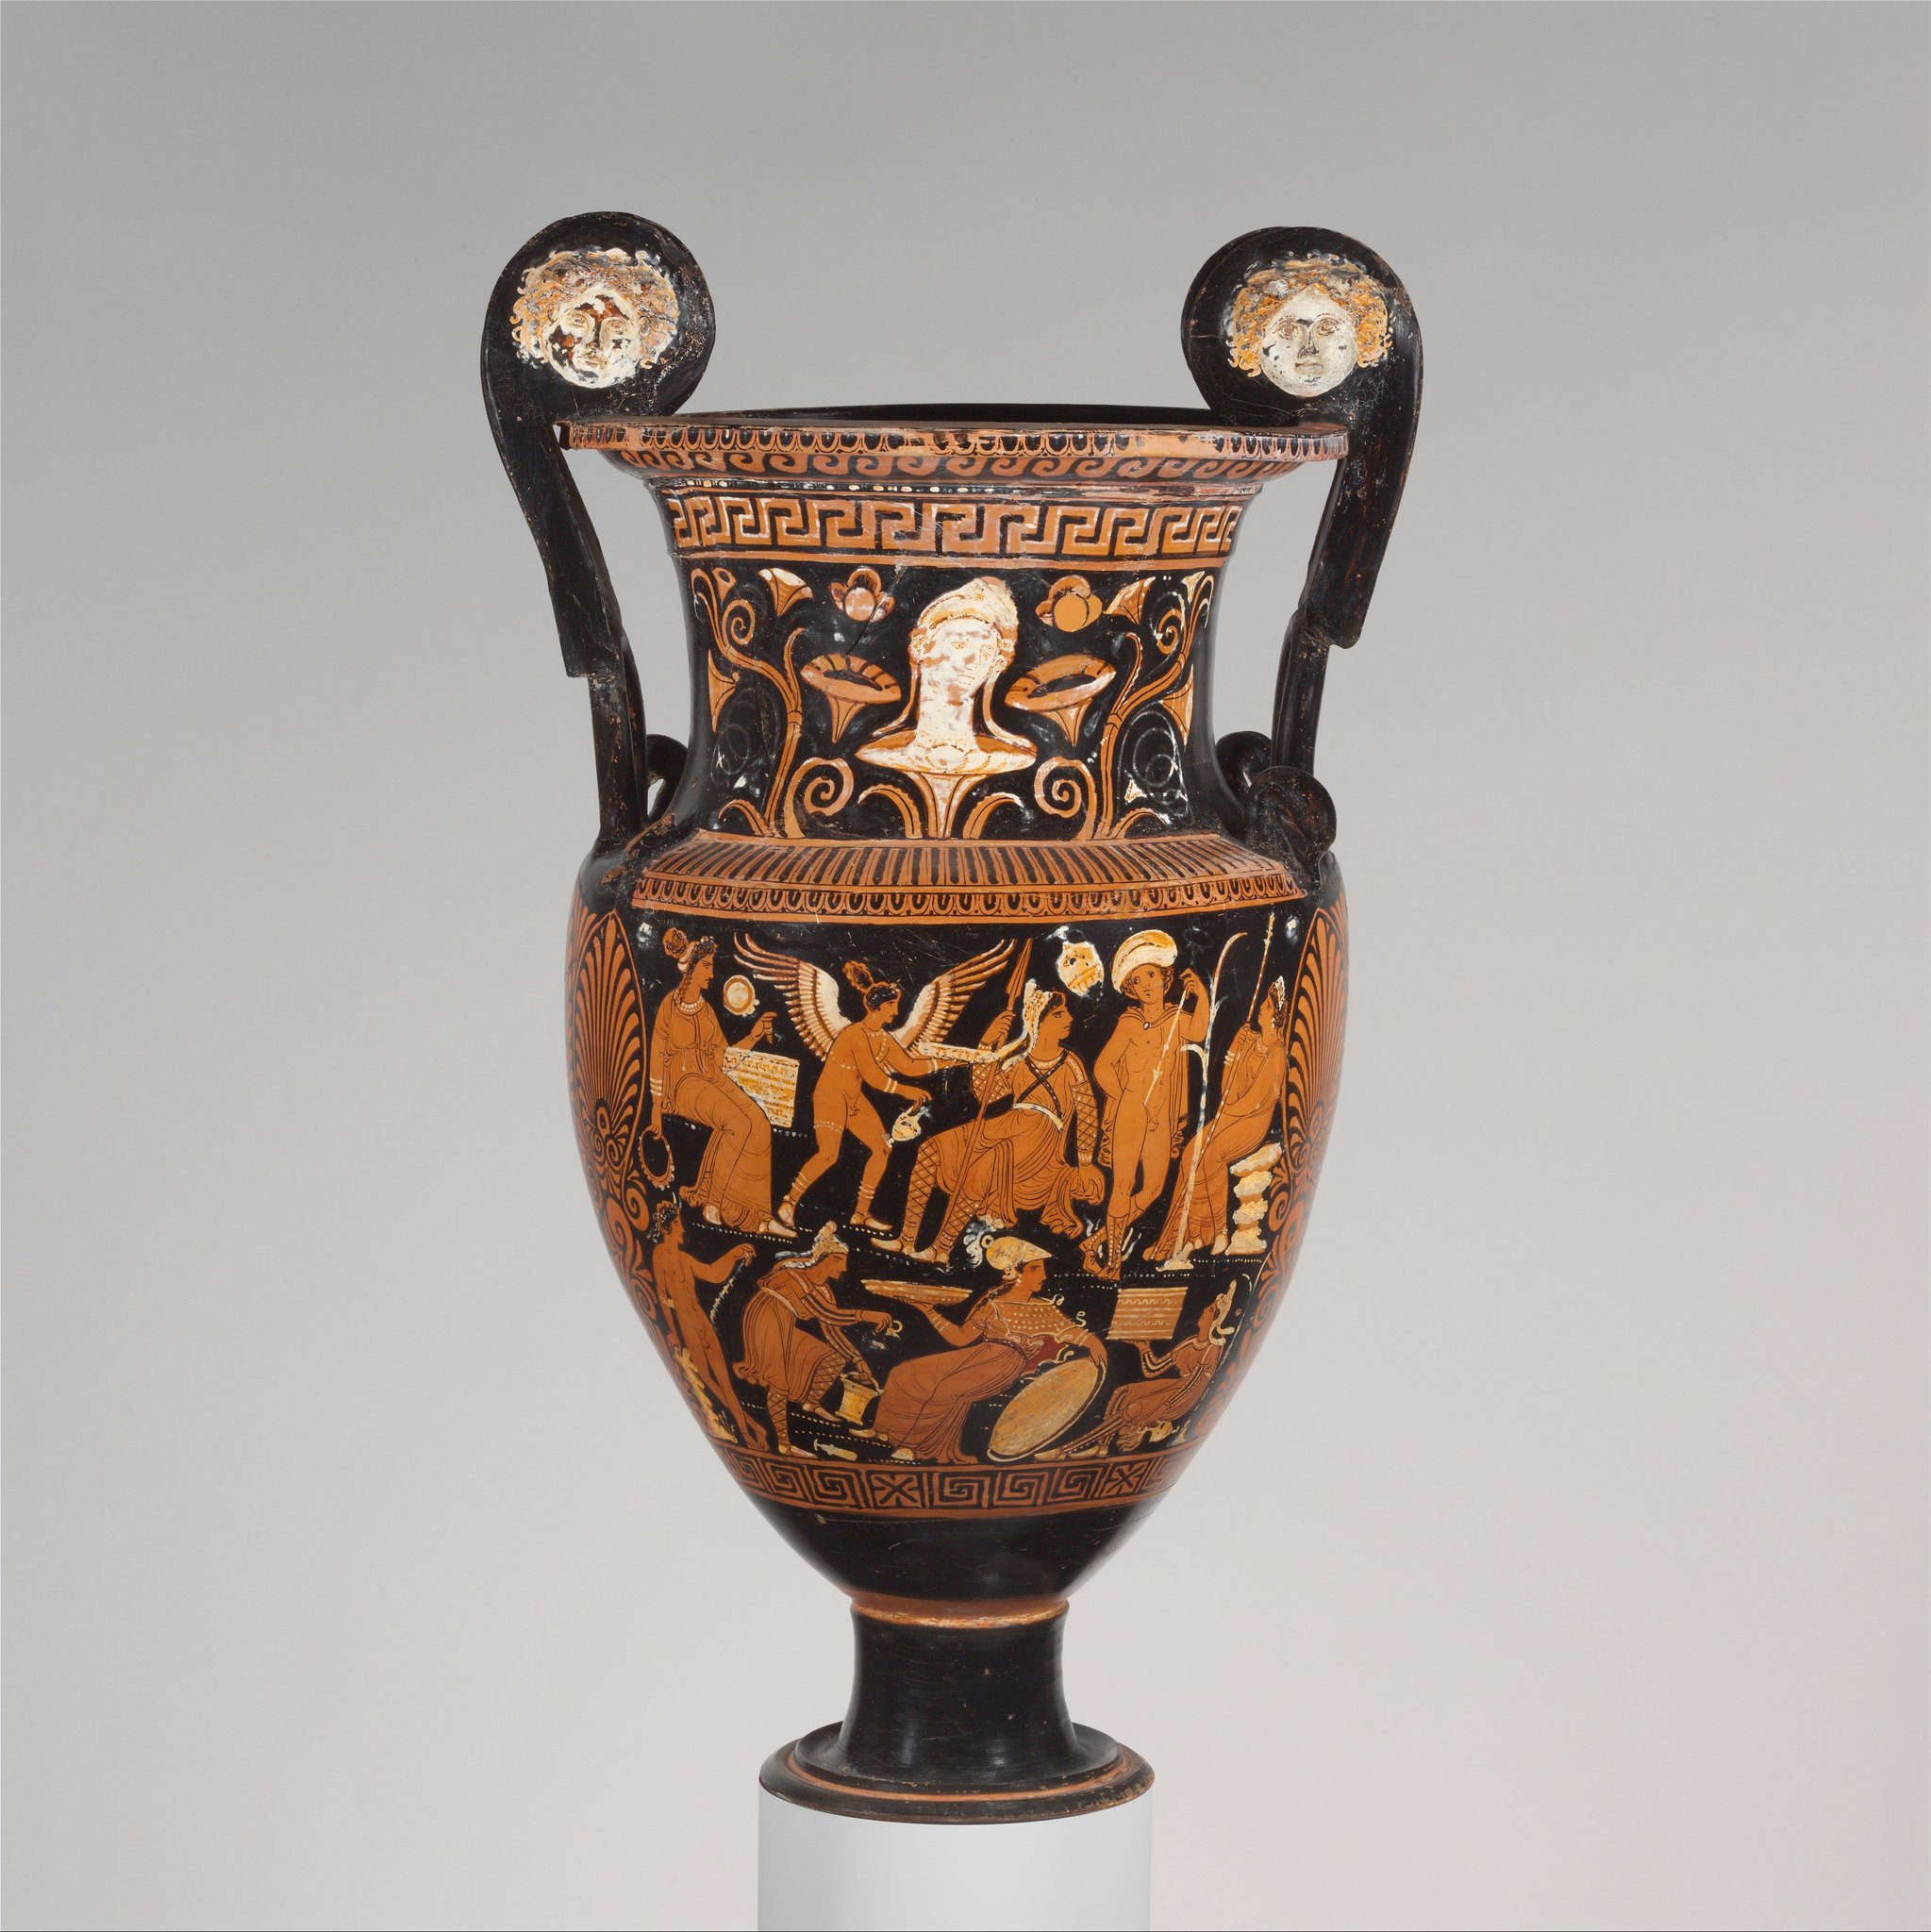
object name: volute krater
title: Terracotta volute-krater (mixing bowl)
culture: greek, south italian, apulian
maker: baltimore painter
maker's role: artist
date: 330-310 BCE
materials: terracotta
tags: male nudes,women,eros,hermes